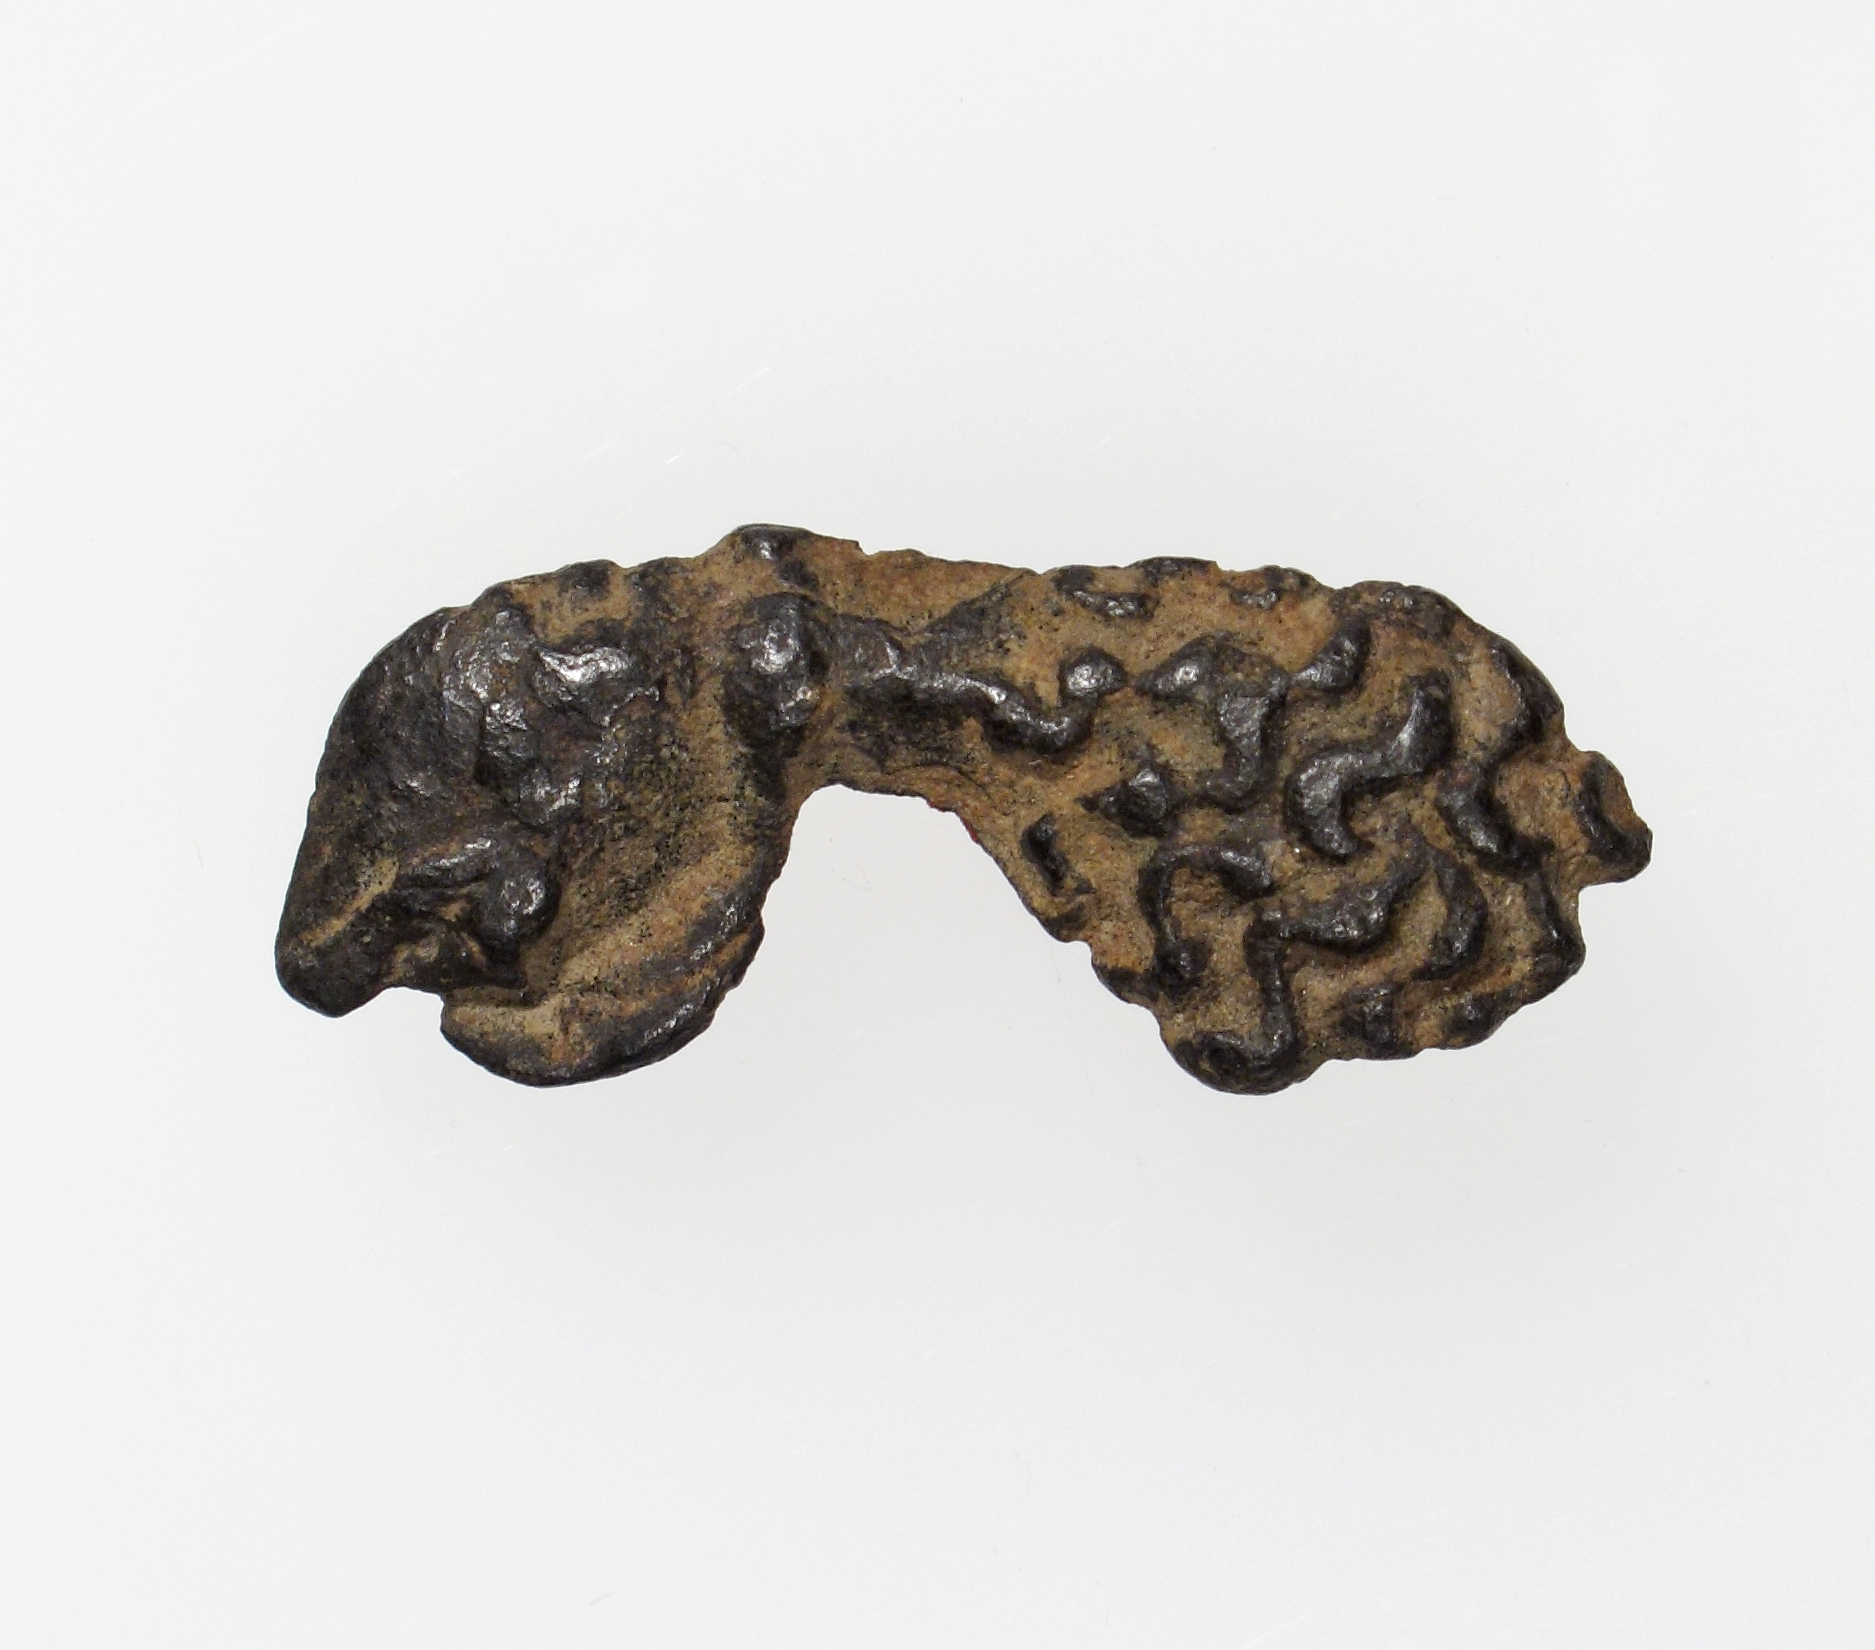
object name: pilgrim's badge fragment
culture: french or british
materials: lead